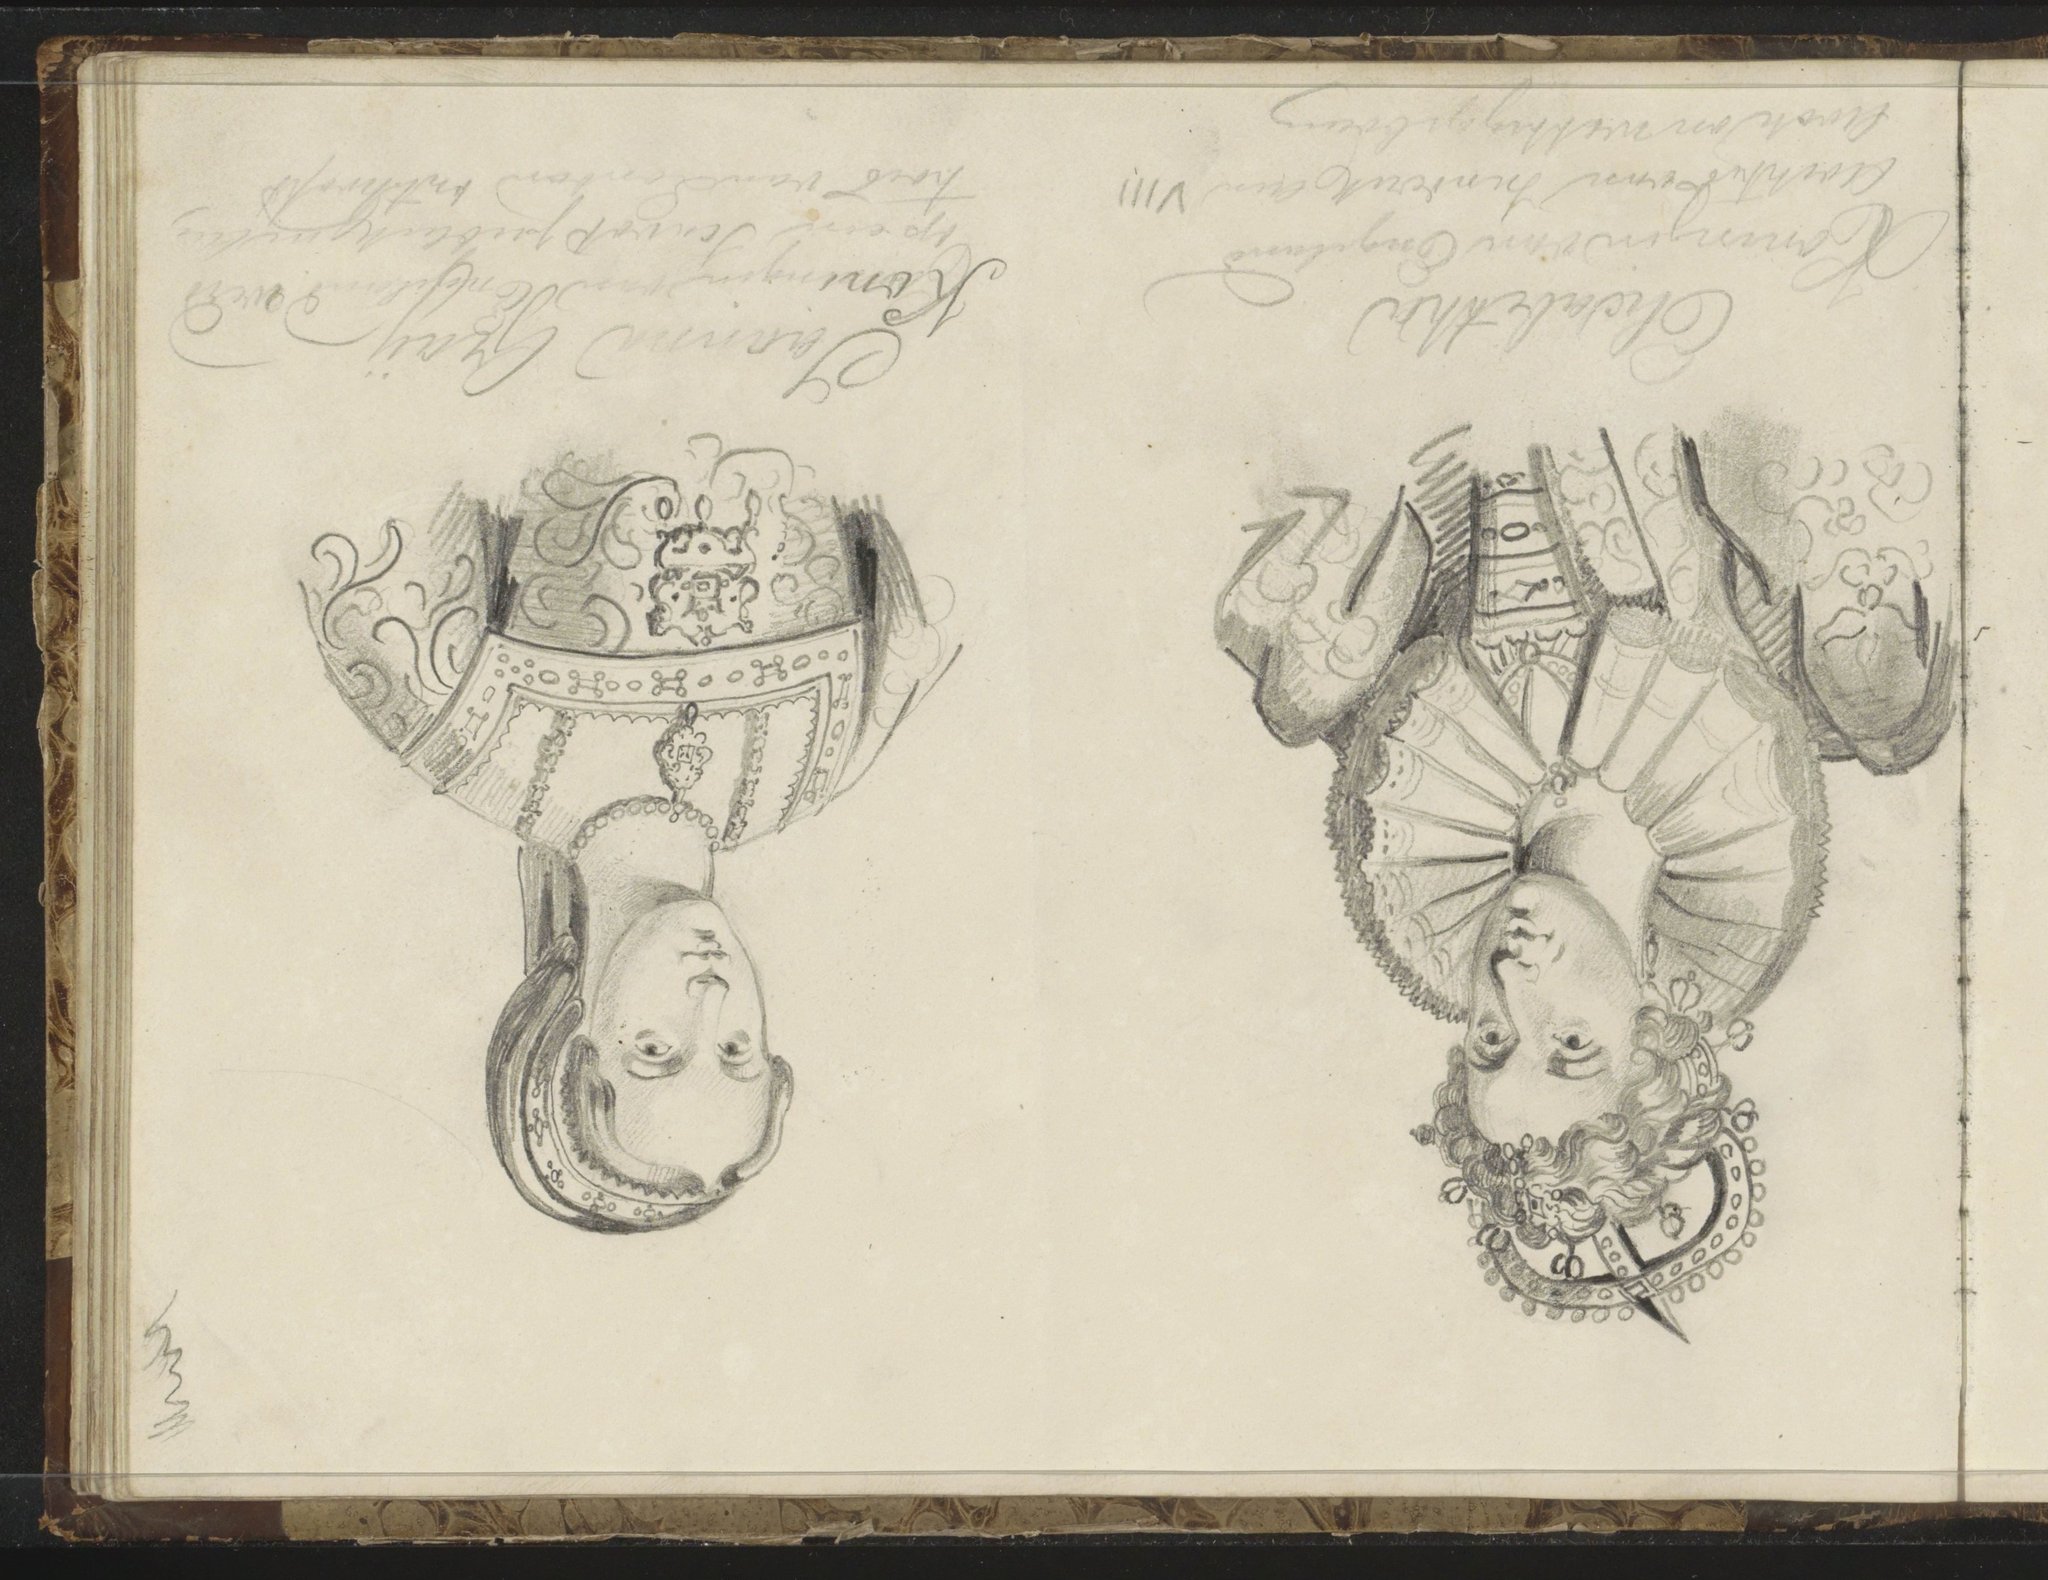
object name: sketchbook leaf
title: Portretten van Elizabeth I Tudor en Lady Jane Gray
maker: willem hendrik schmidt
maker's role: draughtsman, painter, print maker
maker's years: 1809-1849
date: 1819-1849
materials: paper, pencil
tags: historical persons (portraits and scenes from the life) - bb - woman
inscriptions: annotation: ‘Elisabetha/ Koningin van Engeland/ dochter van hendrik van VIII/ [...]/ Joanna Graij/ Koningin van Engeland werd/ op een schavot publiek [...]/ [...] van London onthoofd’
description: Blad 18 verso uit een schetsboek met 52 bladen.